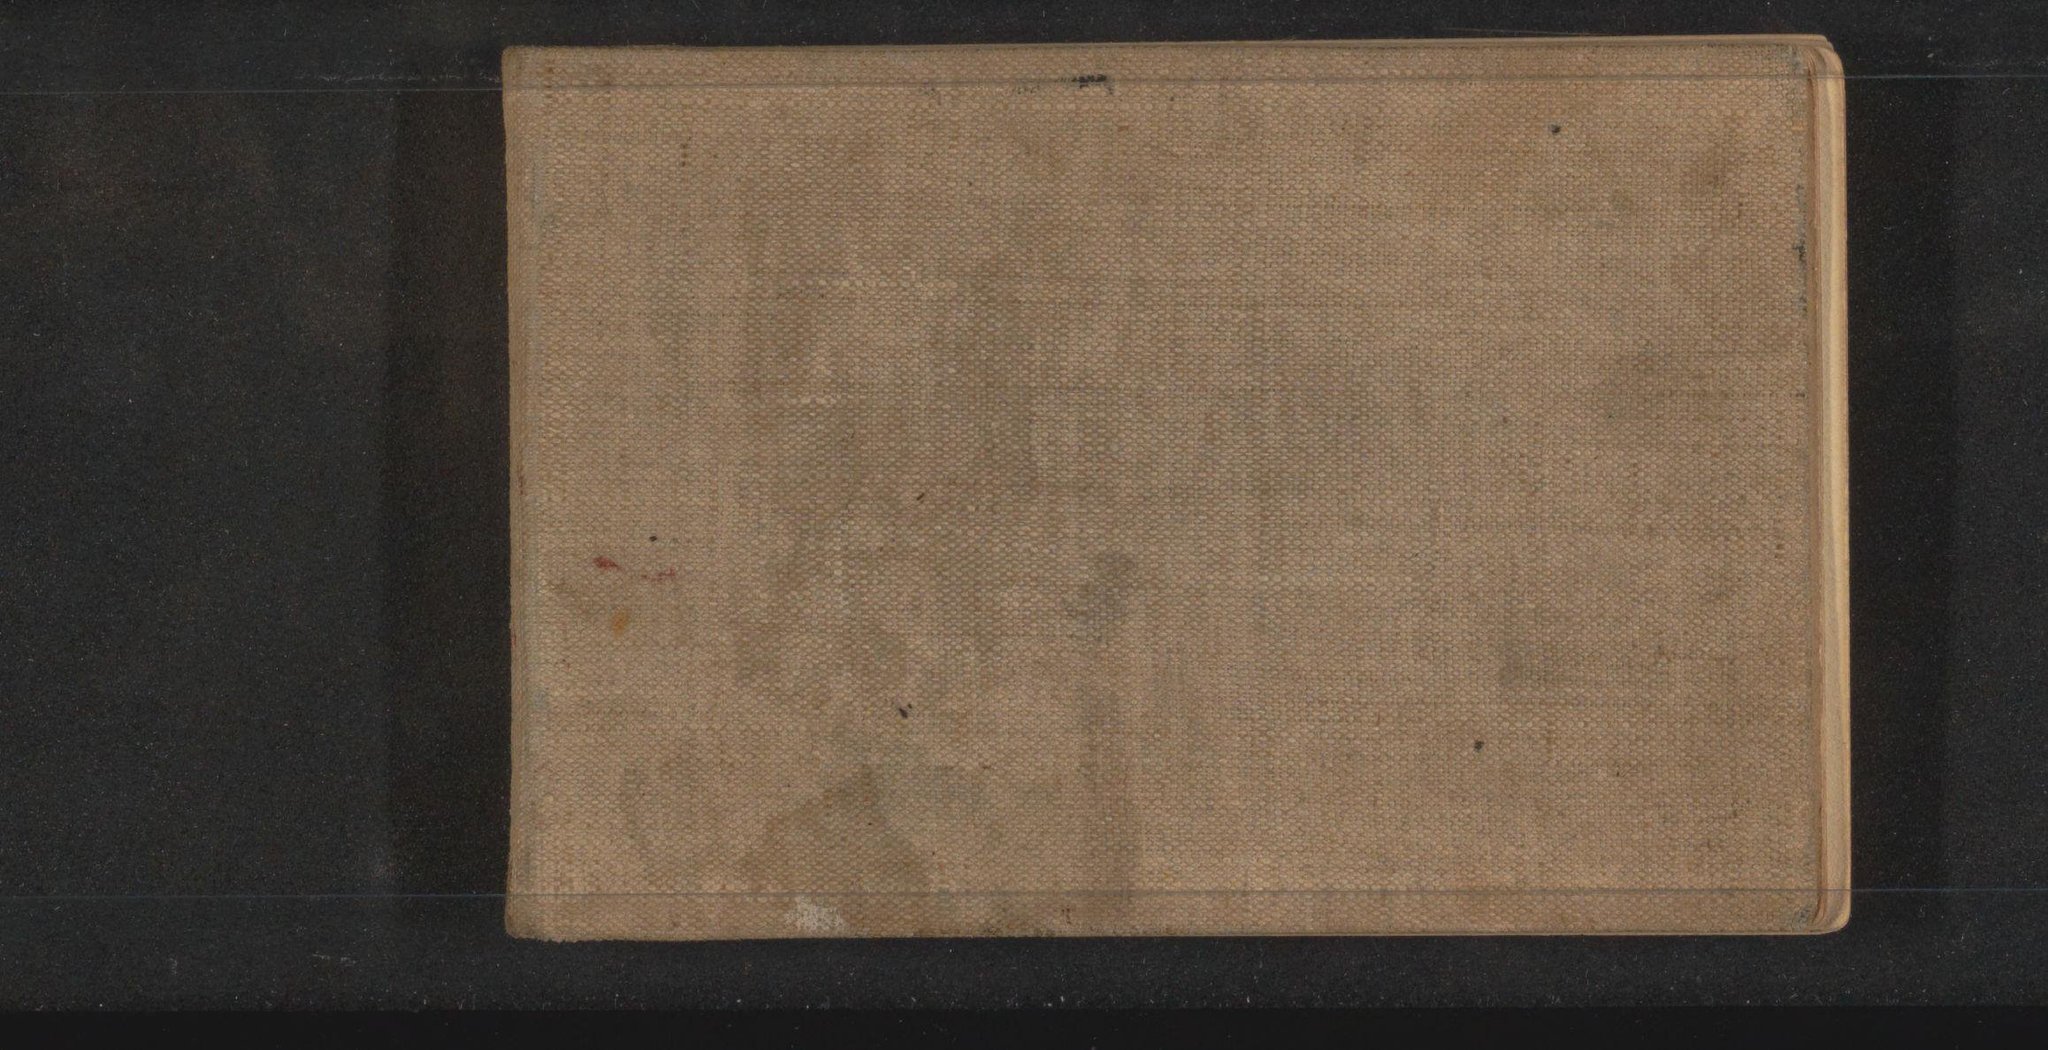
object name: sketchbook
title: Schetsboek met 29 bladen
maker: Anonymous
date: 1880-1900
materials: cardboard, chalk, linen, paper, pencil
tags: landscapes, animals, anonymous historical person portrayed alone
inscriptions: annotation: ‘Harmsen 2.40/ De Jong 2,50/ [...]’, collector's mark: Lugt 2228a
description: Schetsboek bestaande uit 29 bladen met portretten, dieren en landschappen.